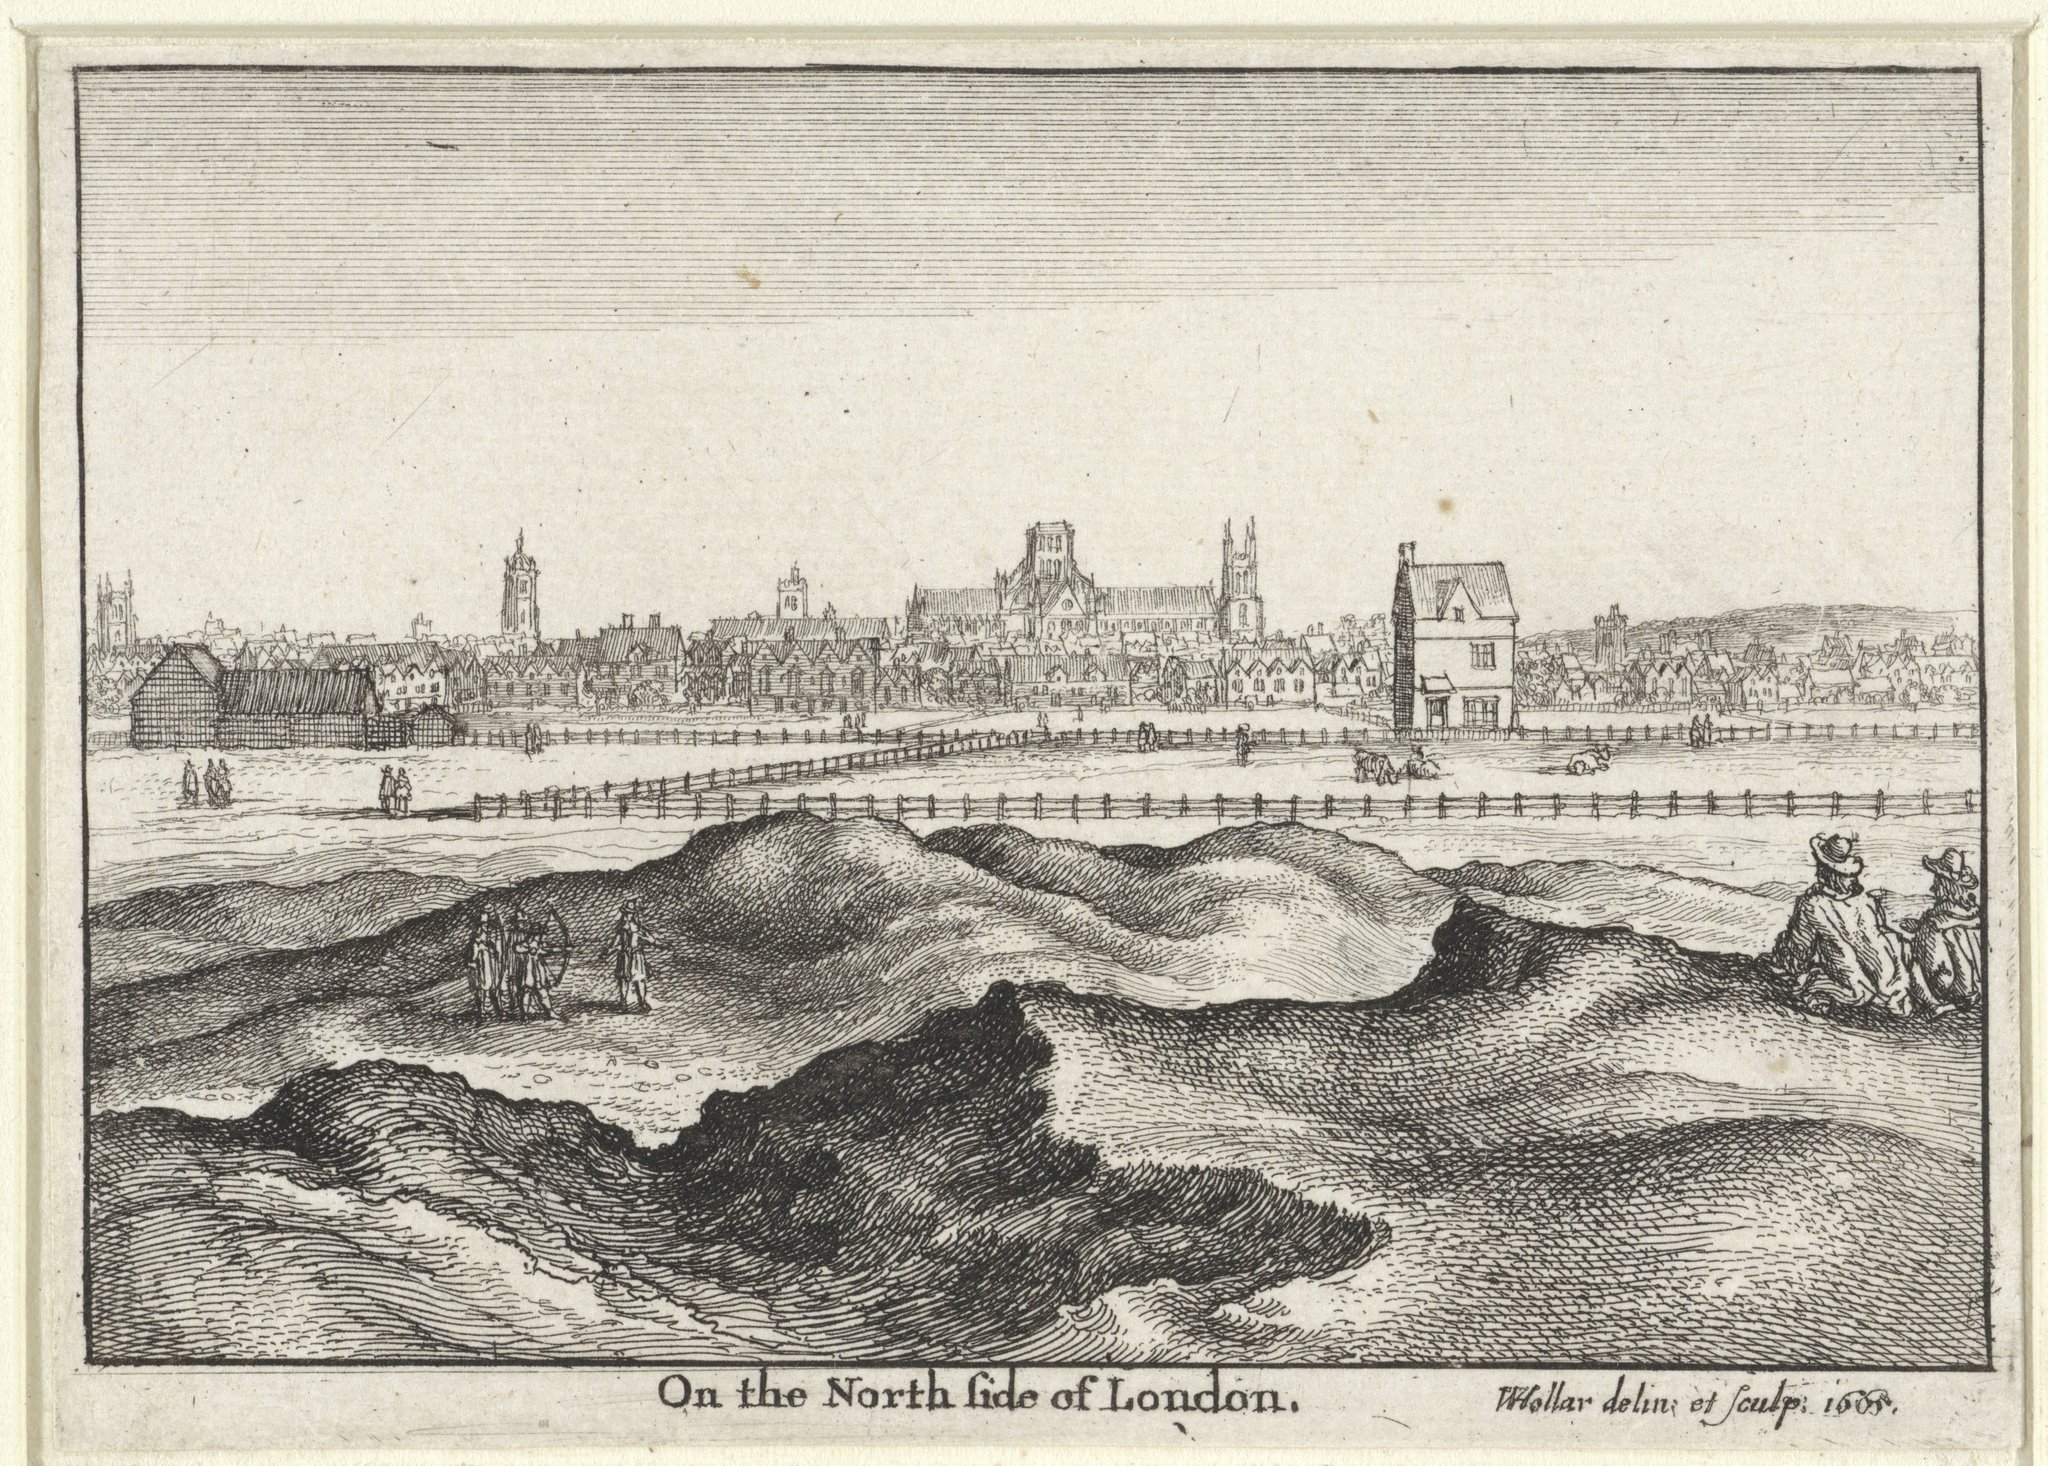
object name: print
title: On the North side of London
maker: wenceslaus hollar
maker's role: draughtsman, print maker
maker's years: 1607-1677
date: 1665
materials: paper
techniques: etching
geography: london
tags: city-view, and landscape with man-made constructions, london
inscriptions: collector's mark: Lugt 240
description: De prent maakt deel uit van een zesdelige serie met gezichten nabij Londen.